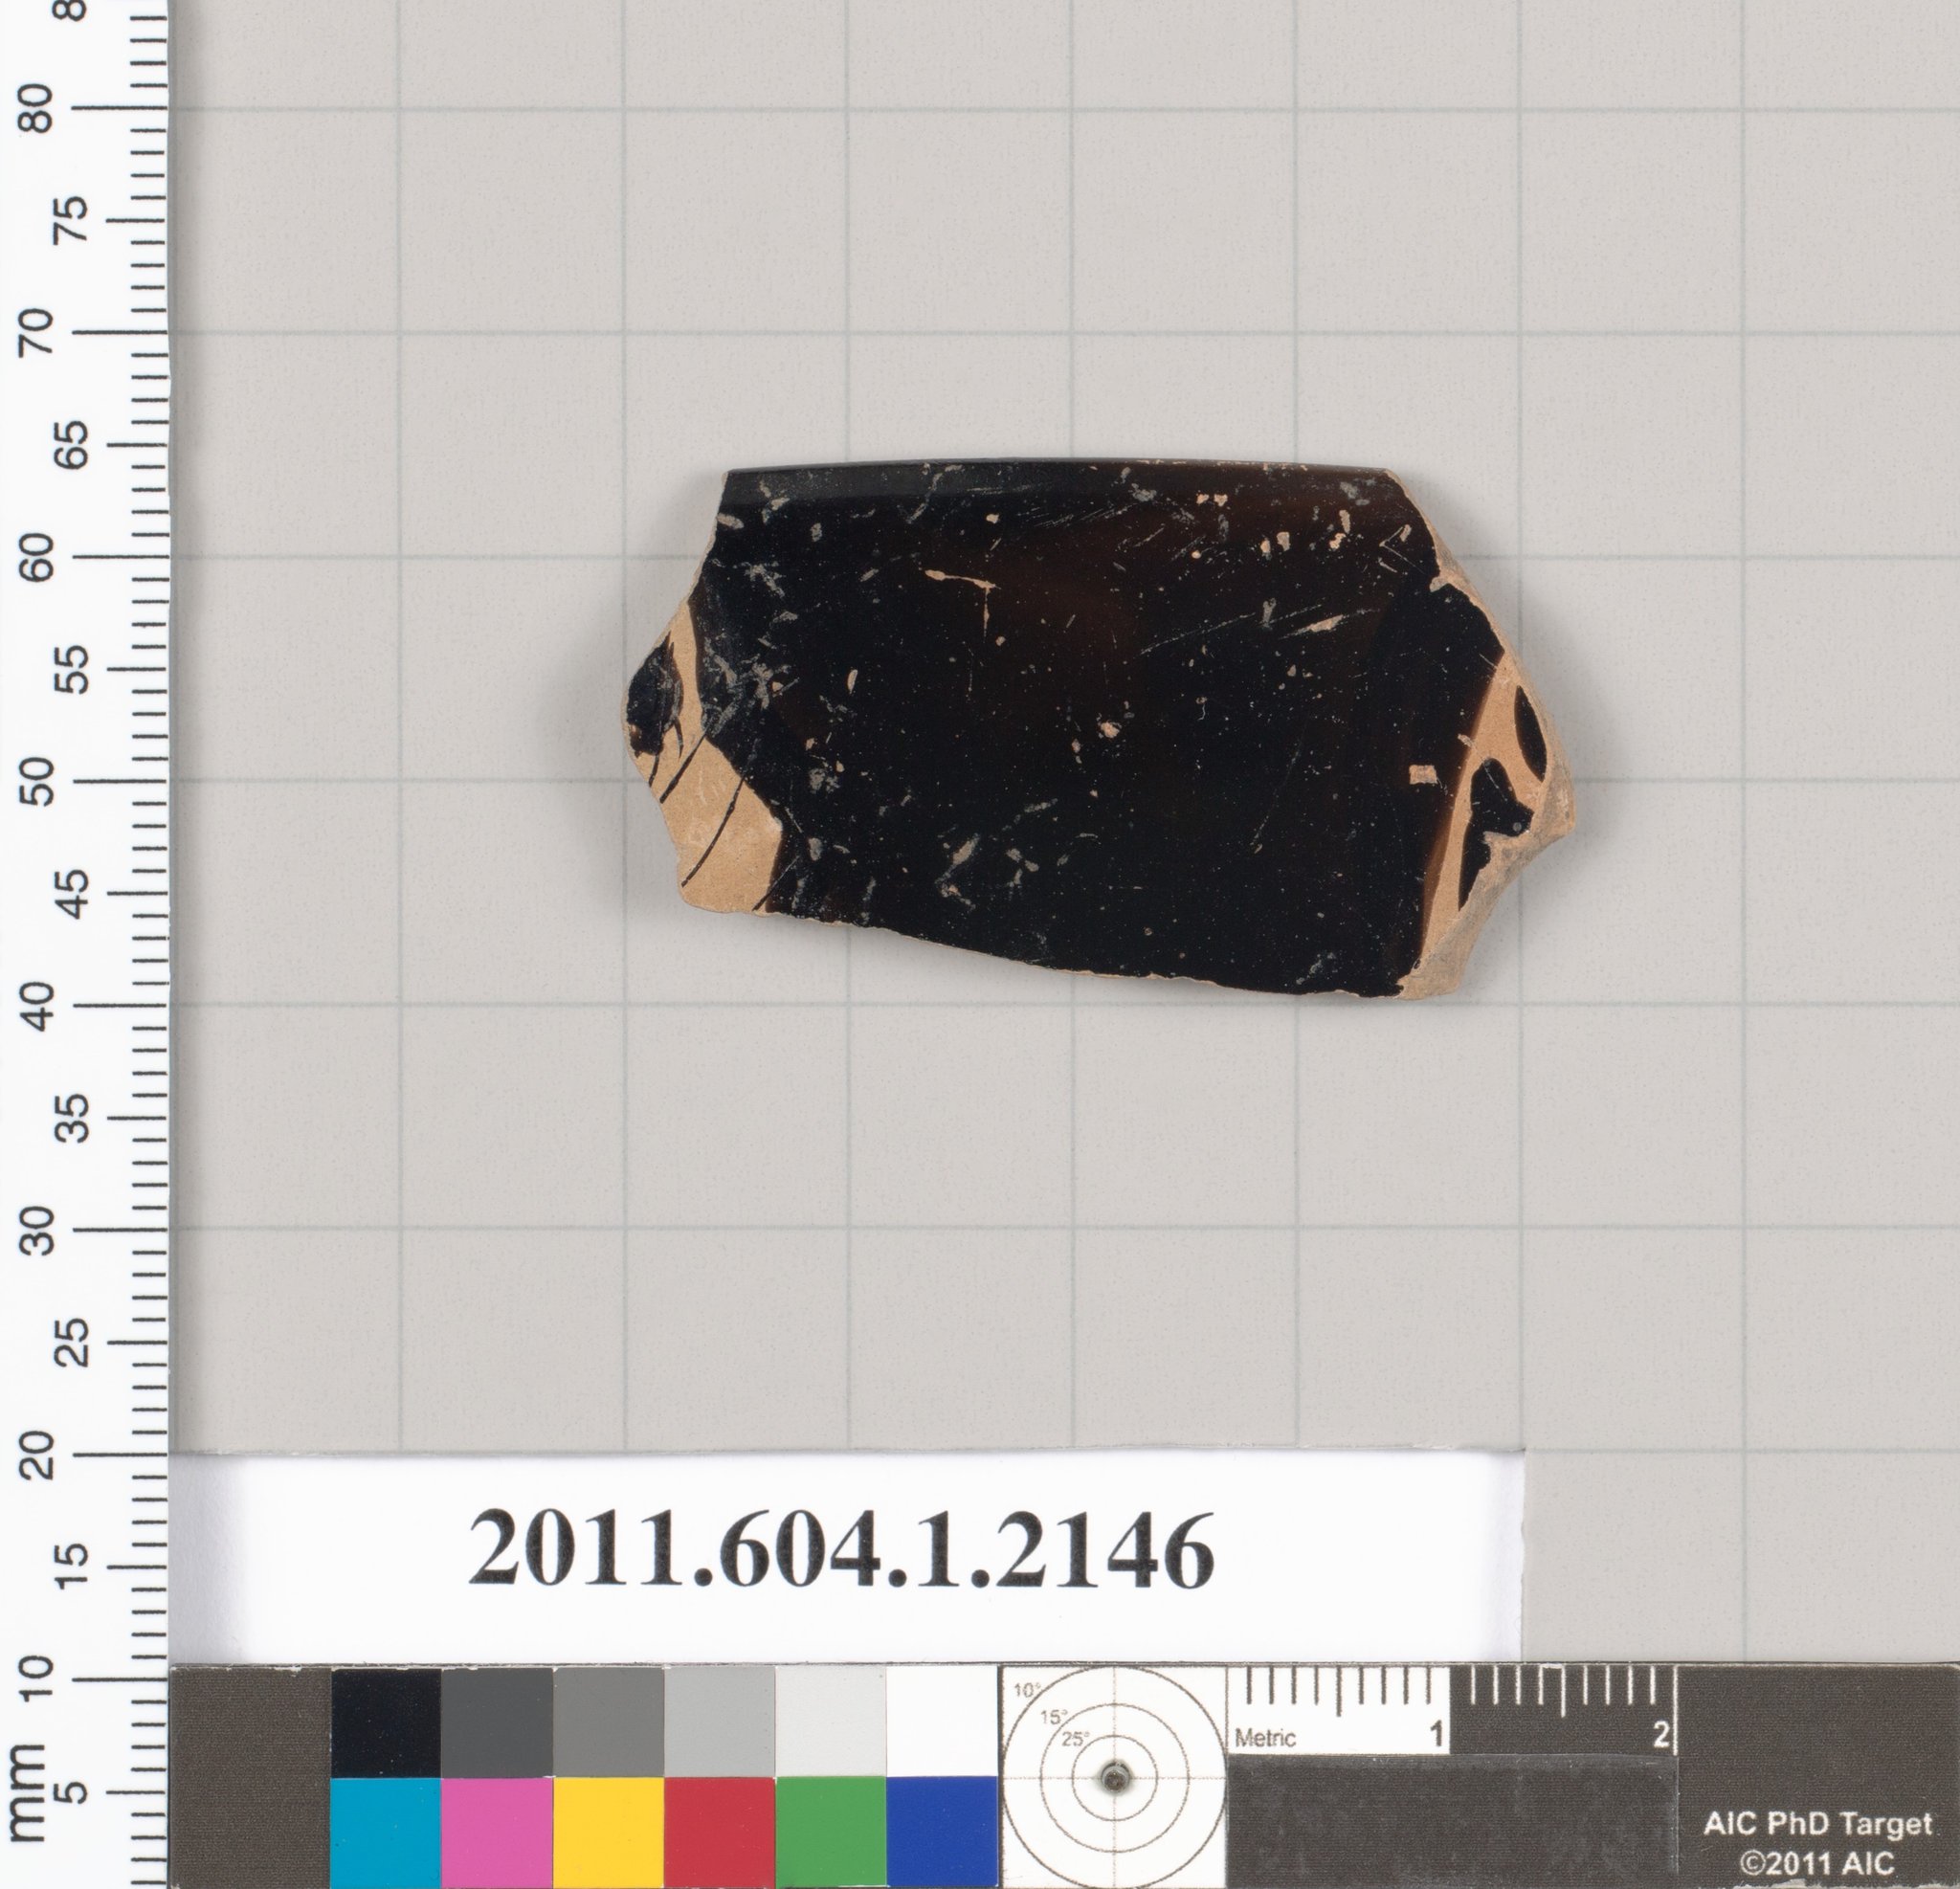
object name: kylix fragment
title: Terracotta rim fragment of a kylix (drinking cup)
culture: greek, attic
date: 500-401 BCE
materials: terracotta